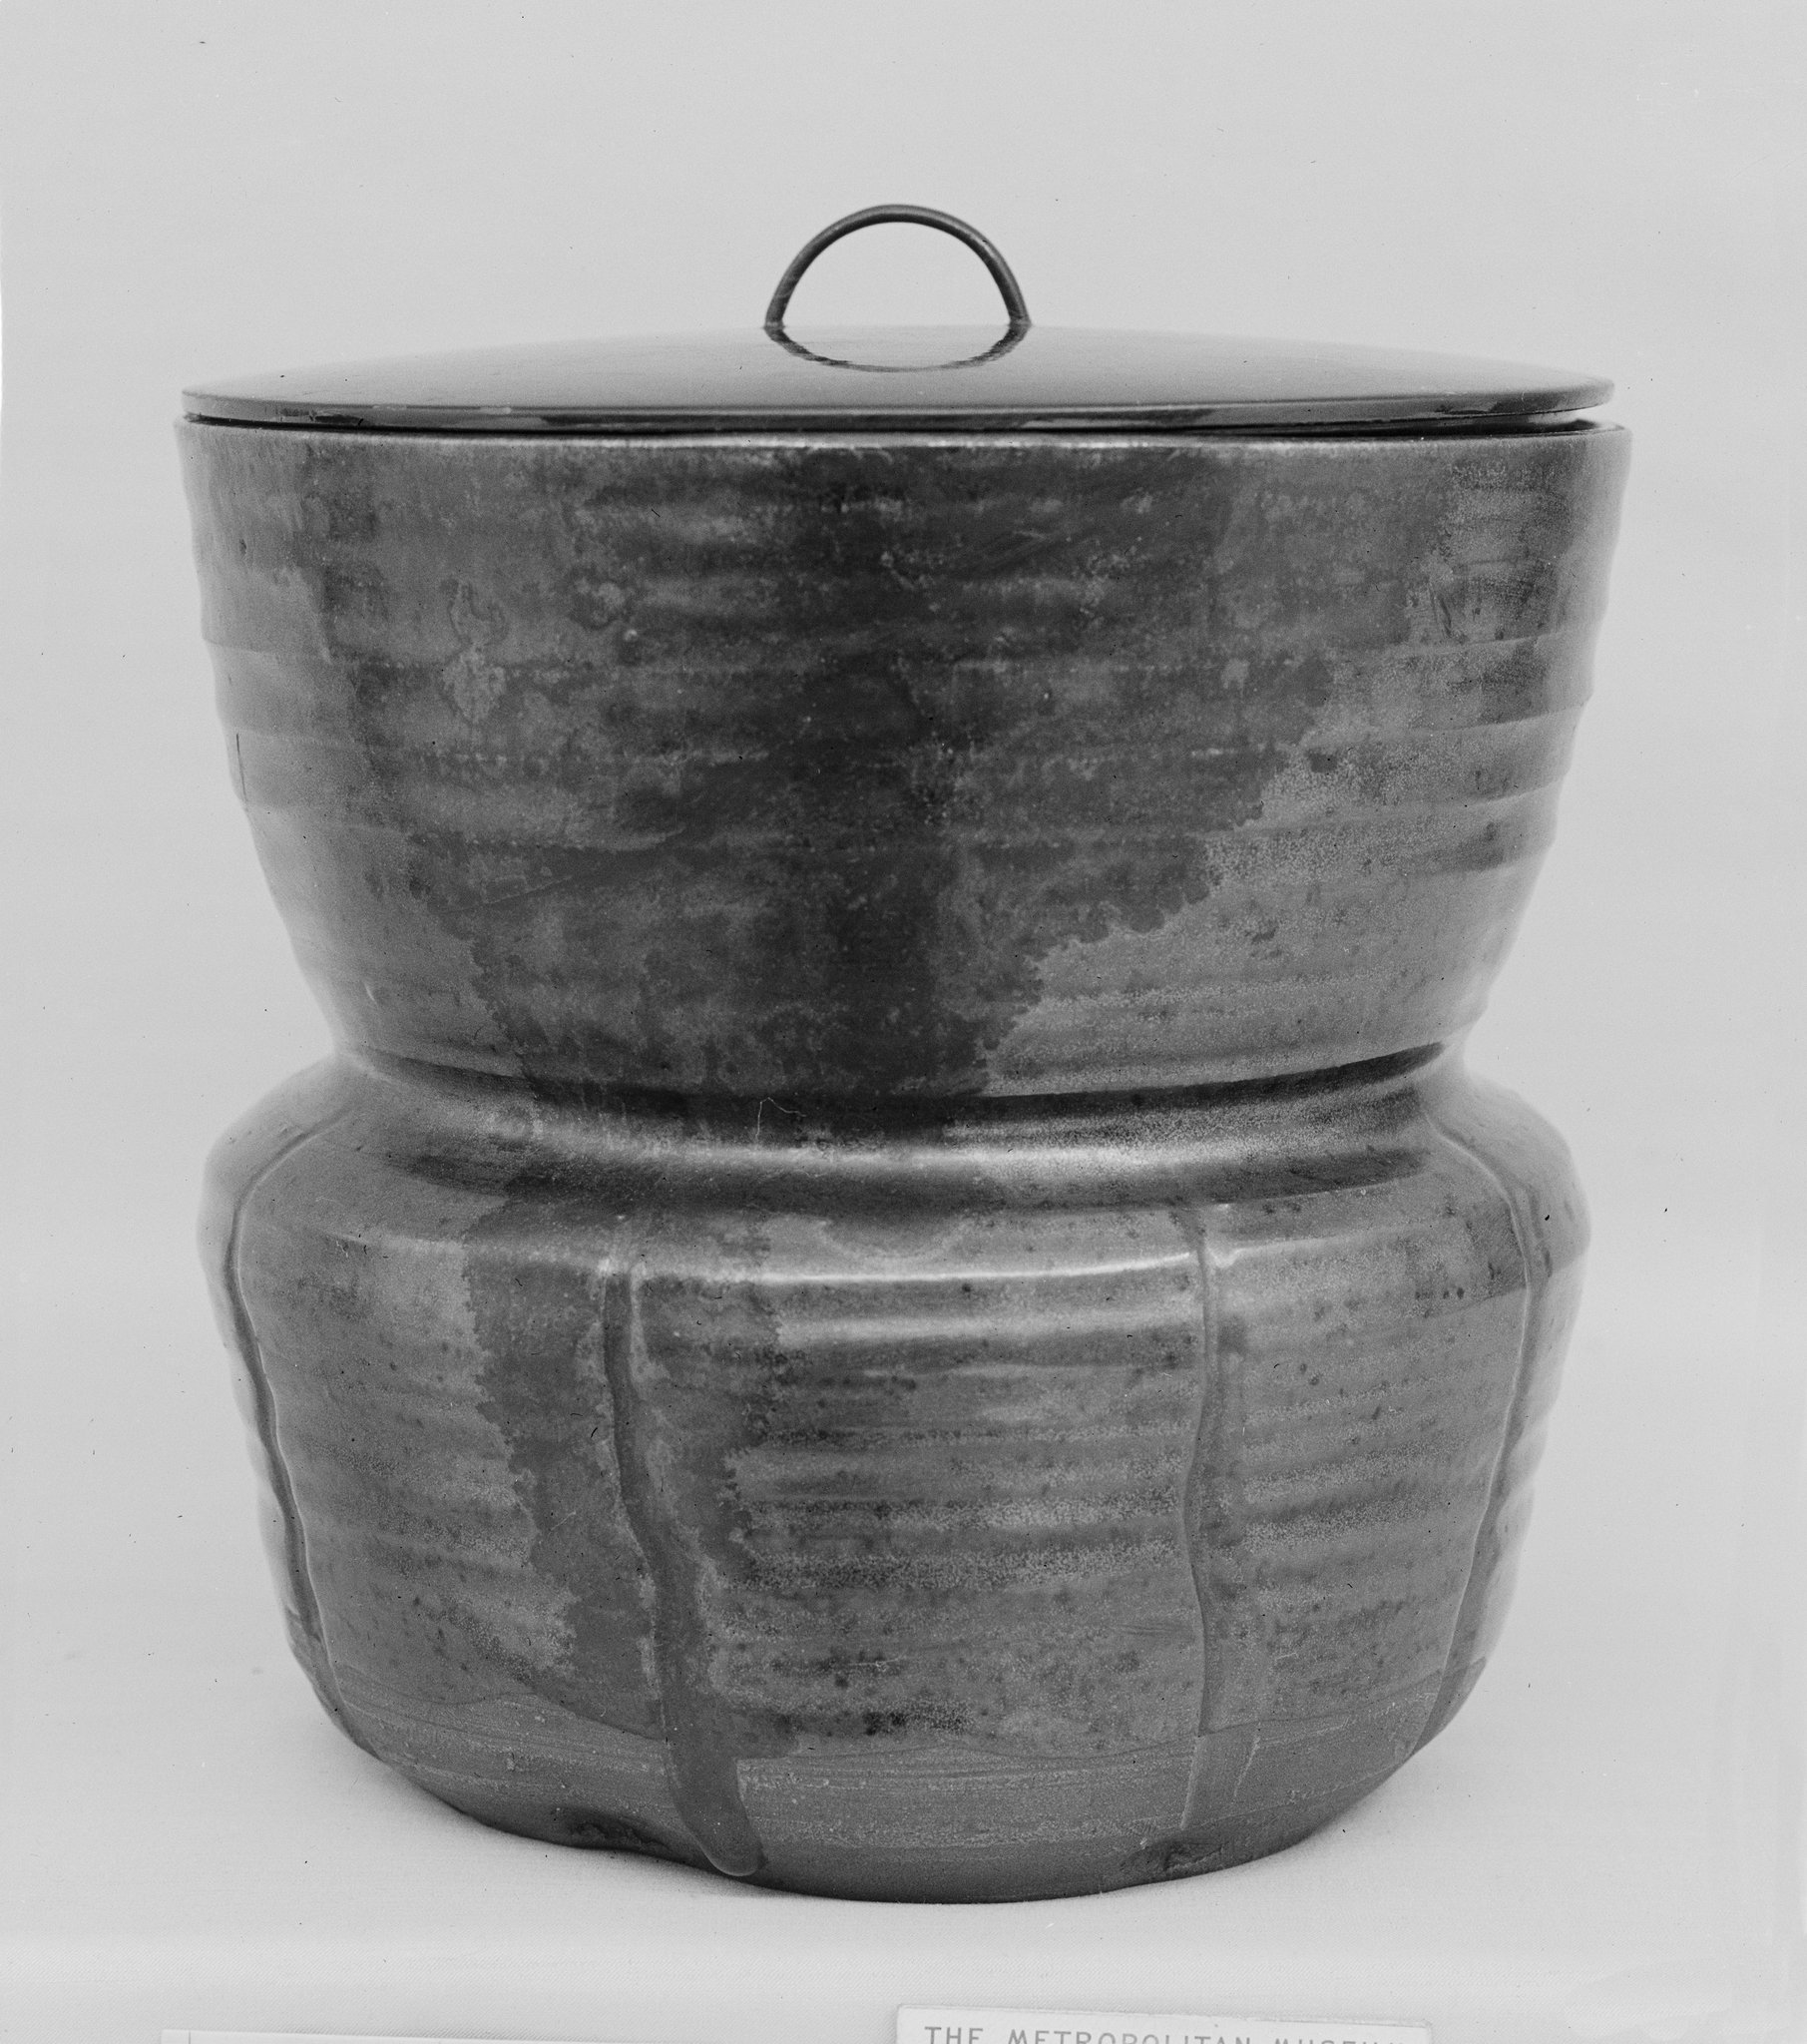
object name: water jar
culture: japanese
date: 1701-1800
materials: clay, glaze